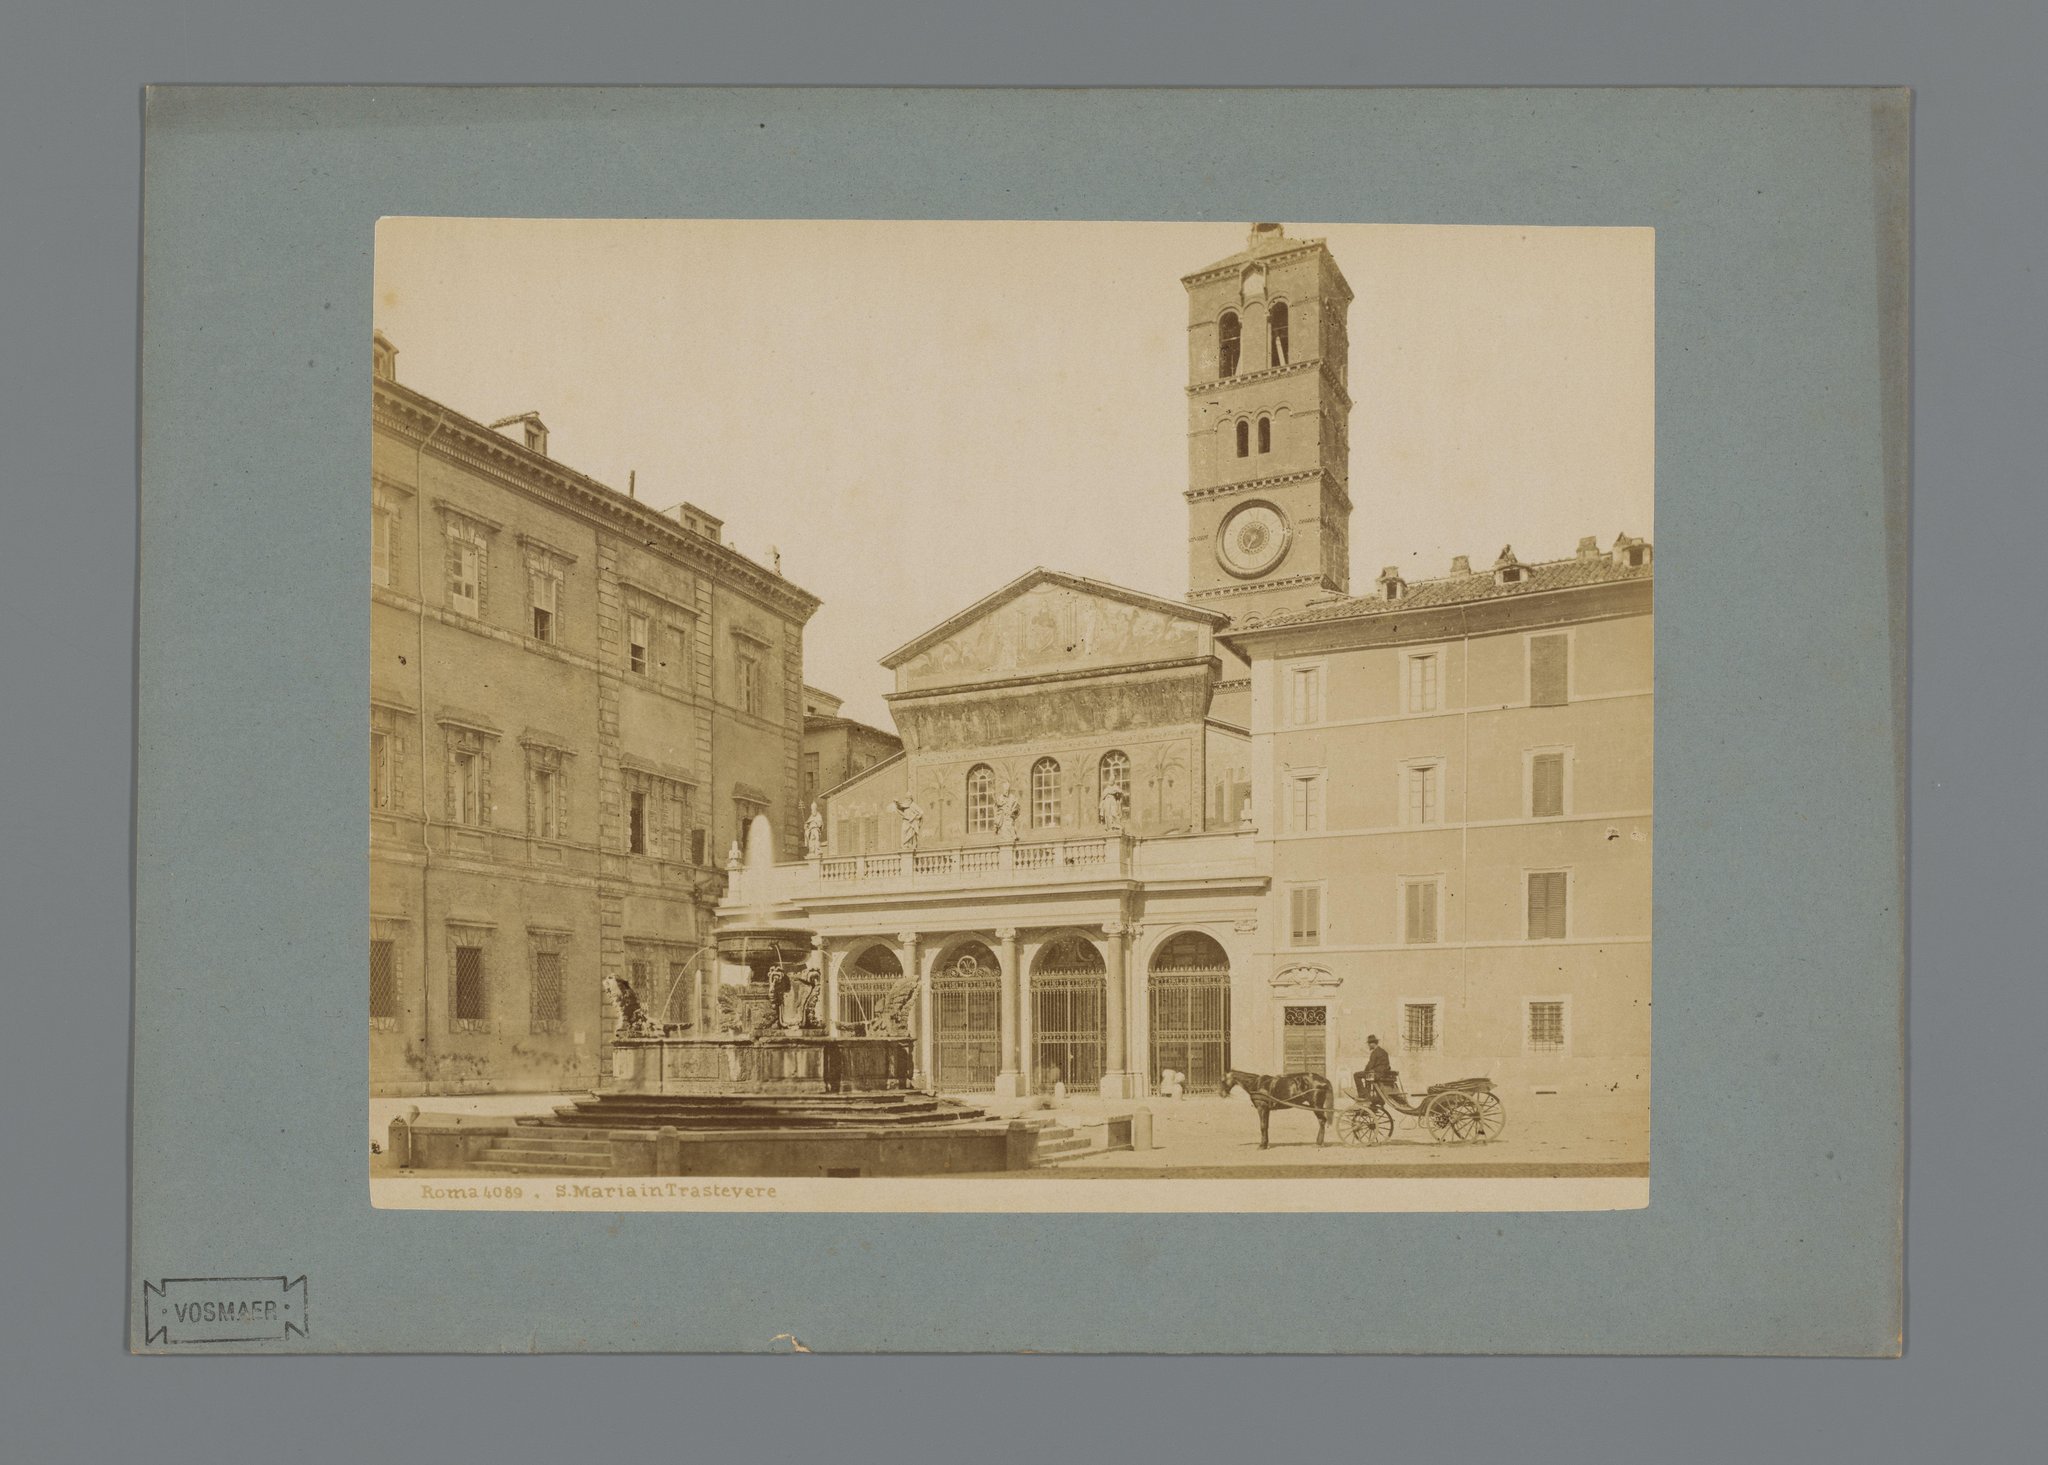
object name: photograph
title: Façade van de Basiliek van Santa Maria in Trastevere te Rome, Italië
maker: Anonymous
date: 1851-1890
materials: cardboard, paper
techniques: albumen print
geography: rome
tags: four-wheeled vehicle drawn by one animal, parts of church exterior and annexes: façade, parts of church exterior and annexes: tower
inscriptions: collector's mark: ‘VOSMAER’, number: ‘4089’